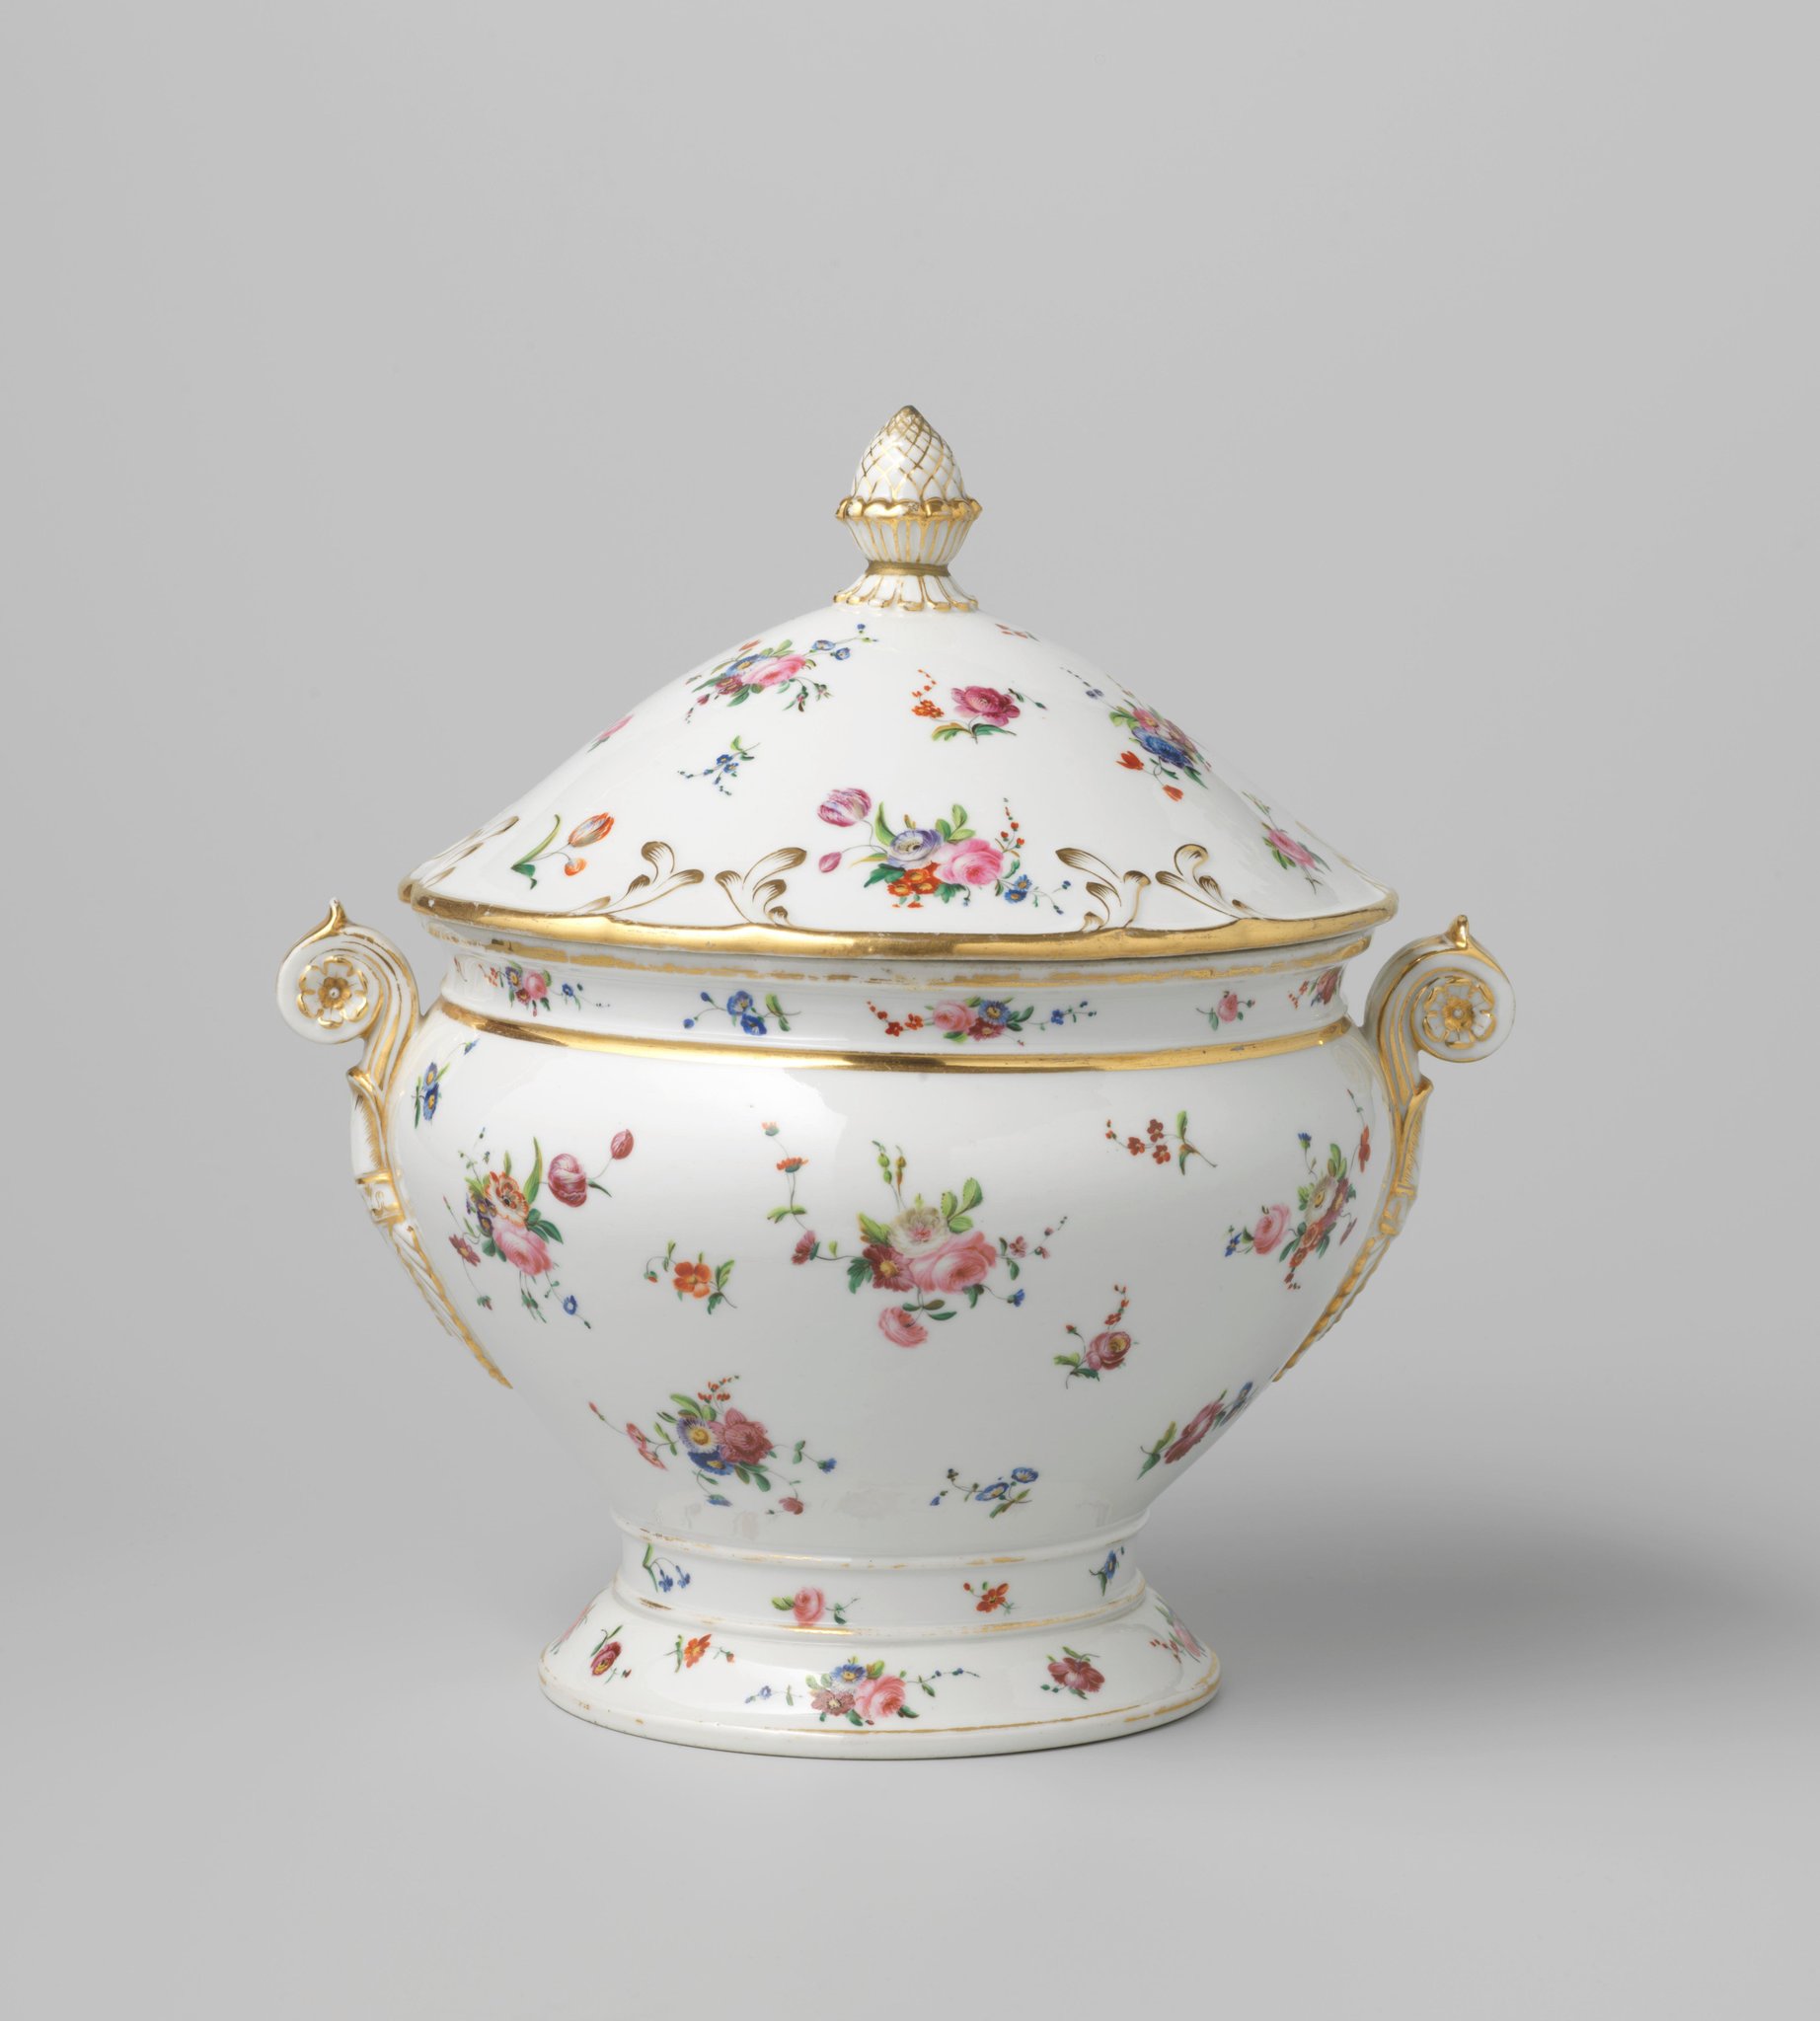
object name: tureen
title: Terrine with bouquets and flower sprays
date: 1839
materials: glaze, gold, paint, porcelain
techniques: firing, forming, gilding, turning, vitrification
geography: paris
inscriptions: mark: ‘DENUELLE/ Boulevard St. Denis 18/ à Paris’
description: Terrine met deksel van porselein met een gedrukt, eivormig lichaam, hoge, spreidende voet en iets spreidende rand. De terrine heeft twee handvatten in de vorm van een bladrank met een rozet in de krul en een palmet als basis. Beschilderd op het glazuur in blauw, rood, roze, groen, geel, paars, zwart en goud. Versierd met boeketten van verschillende bloemen en strooibloemen. Op de deksel vanuit de gelobde, gouden rand, gemodelleerde bladranken, aangezet met goud. Dekselknop in de vorm van een pijnappel. Gemerkt op de onderzijde met 'DENUELLE/ Boulevard St. Denis 18/ à Paris'.